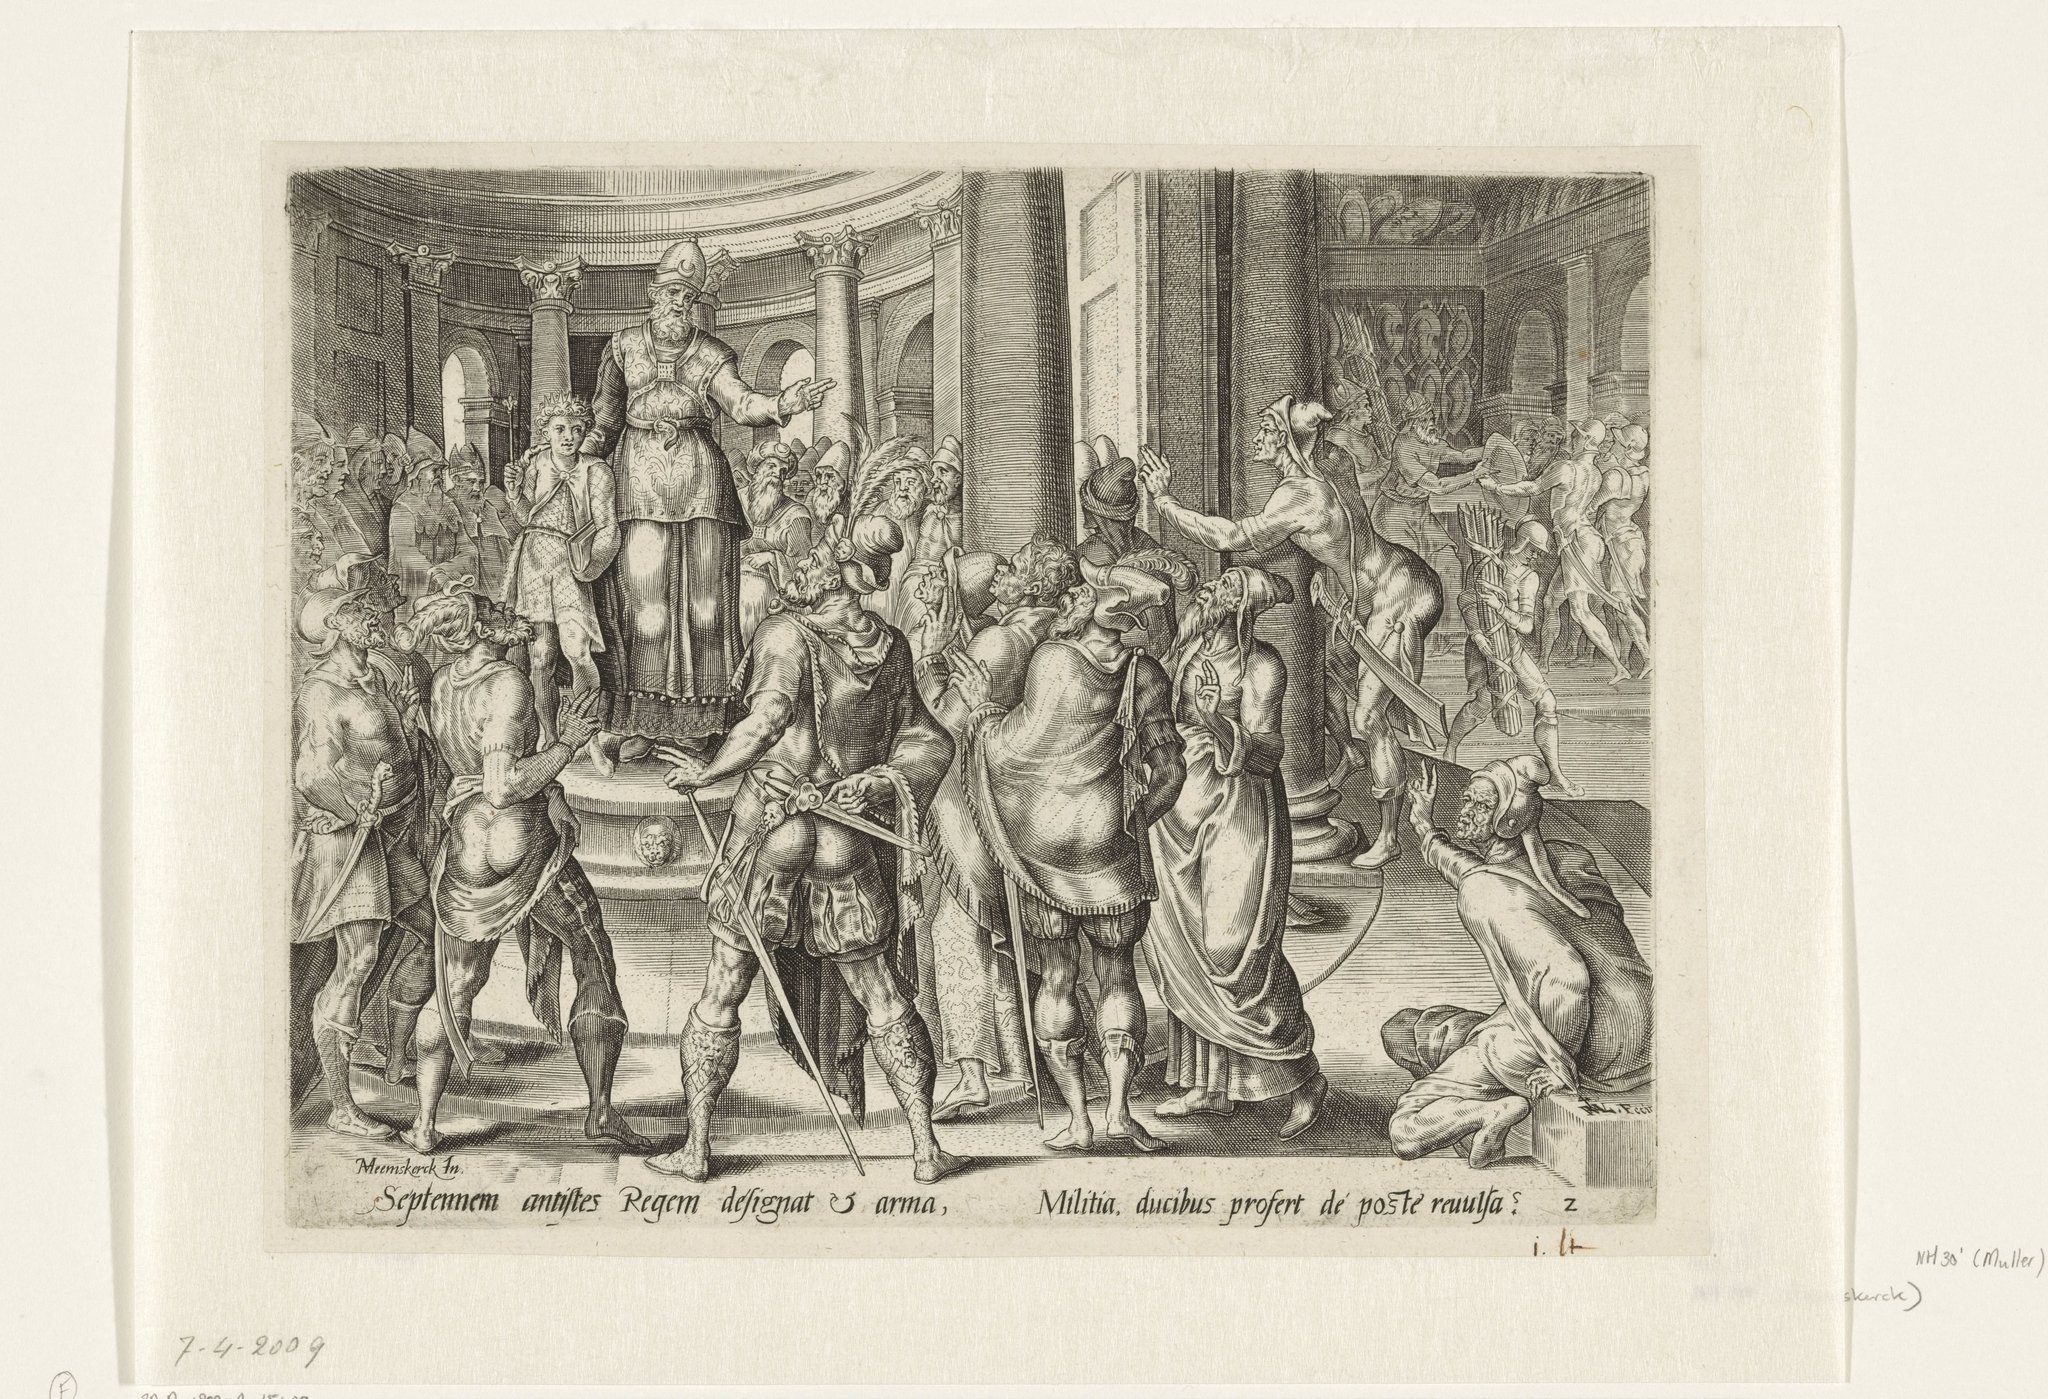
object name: print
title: Geschiedenis van Joas en koningin Atalja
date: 1565-1569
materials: paper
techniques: engraving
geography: antwerp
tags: jehoiada gathers a group of soldiers, presents joash to them and persuades them to swear allegiance to him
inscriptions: collector's mark: Lugt 2228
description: Op een verhoging in de tempel stelt de hogepriester koning Joas voor aan de koninklijke garde. De mannen zweren trouw aan de koning. Rechts achteraan worden speren en de schilden uitgedeeld. Onderaan in de marge een vers in het Latijn over de voorstelling.